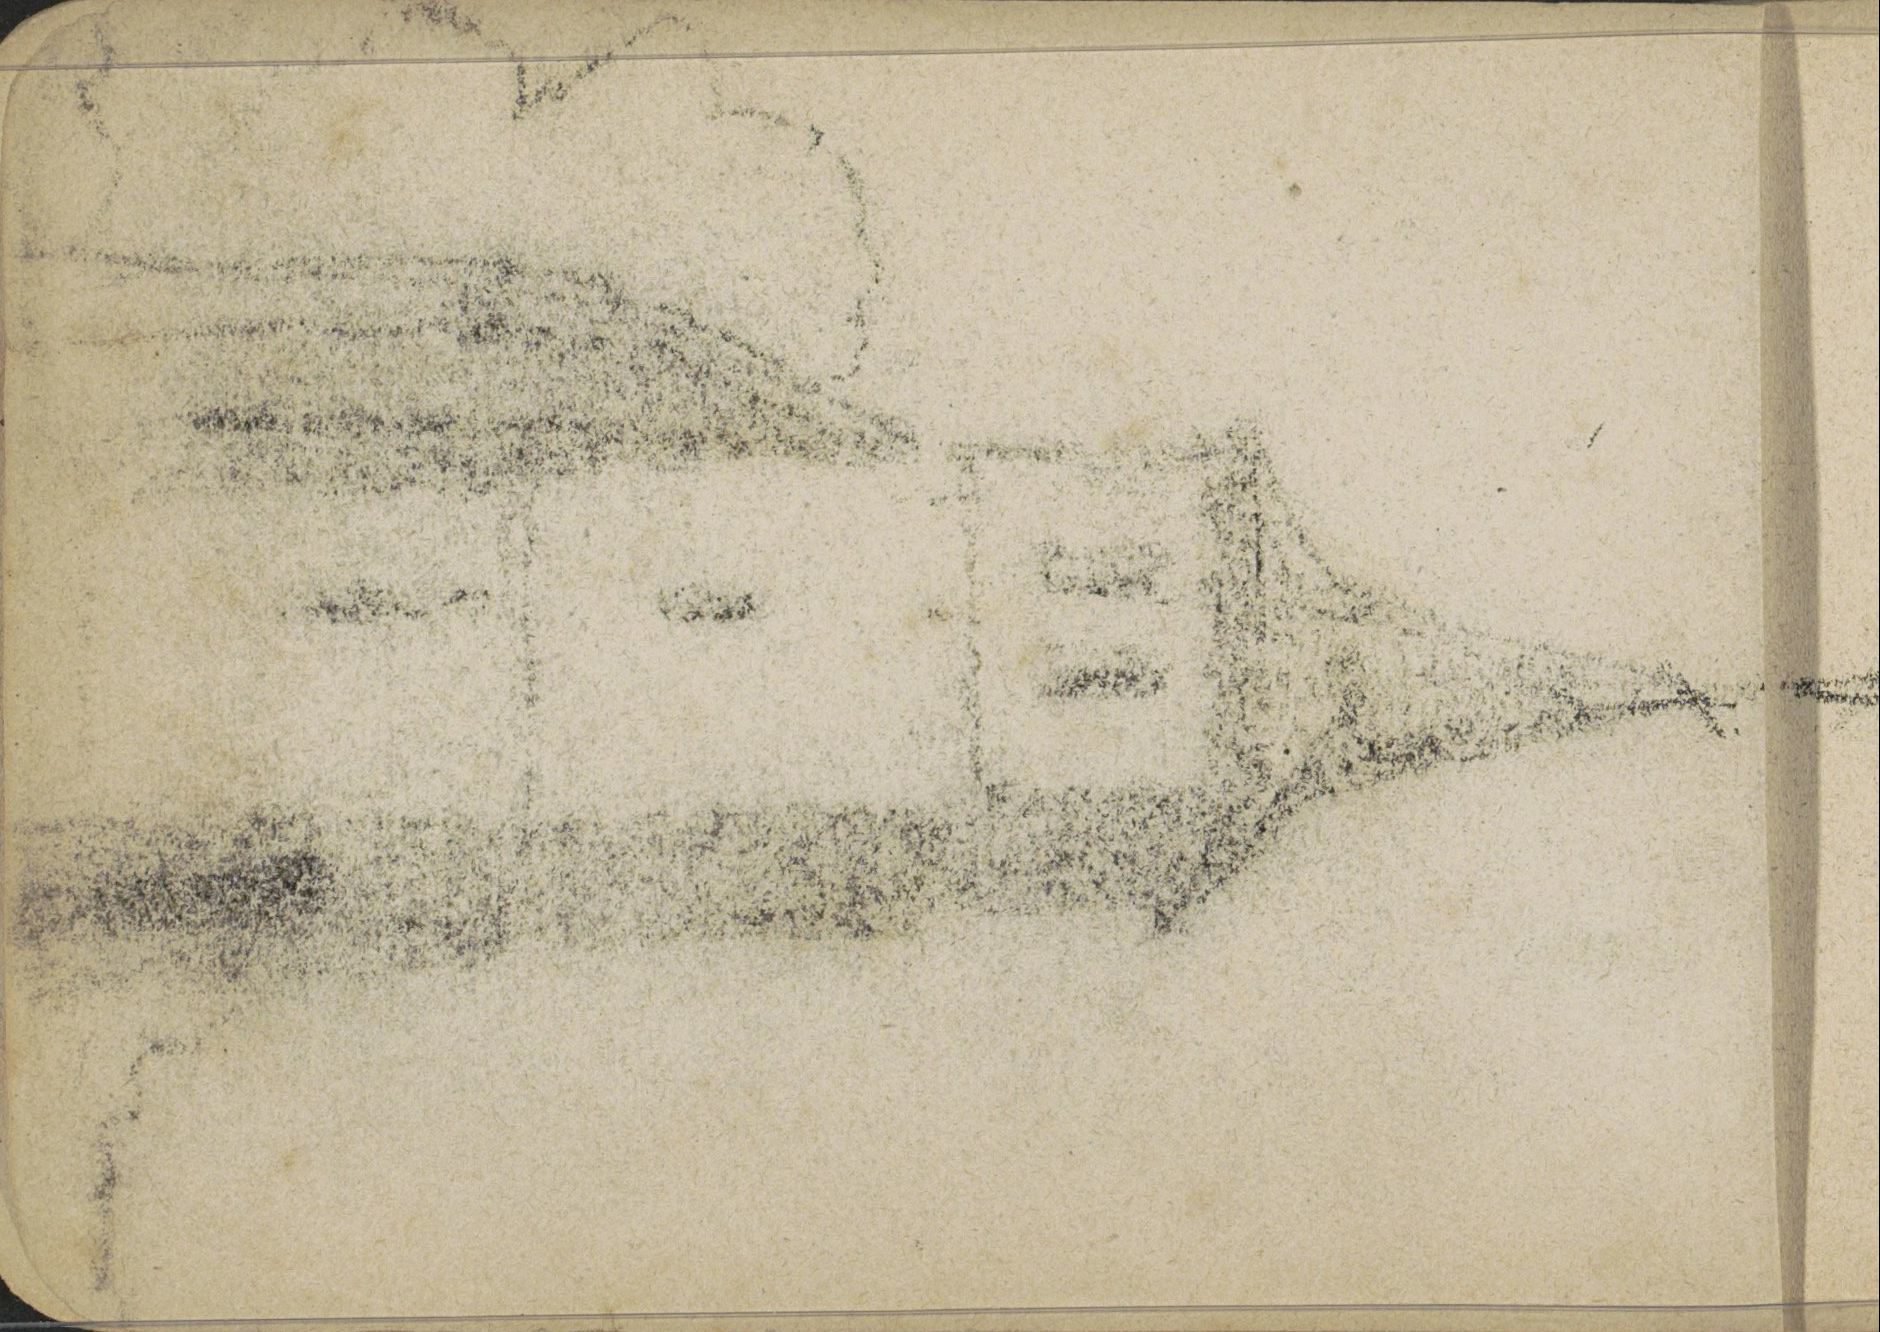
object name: sketchbook leaf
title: Abklatsch van de krijttekening op blad 2 recto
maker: willem cornelis rip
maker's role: draughtsman, painter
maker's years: 1856-1922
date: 1896-1897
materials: paper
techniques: printmaking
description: Blad 1 verso uit een schetsboek met 44 bladen.